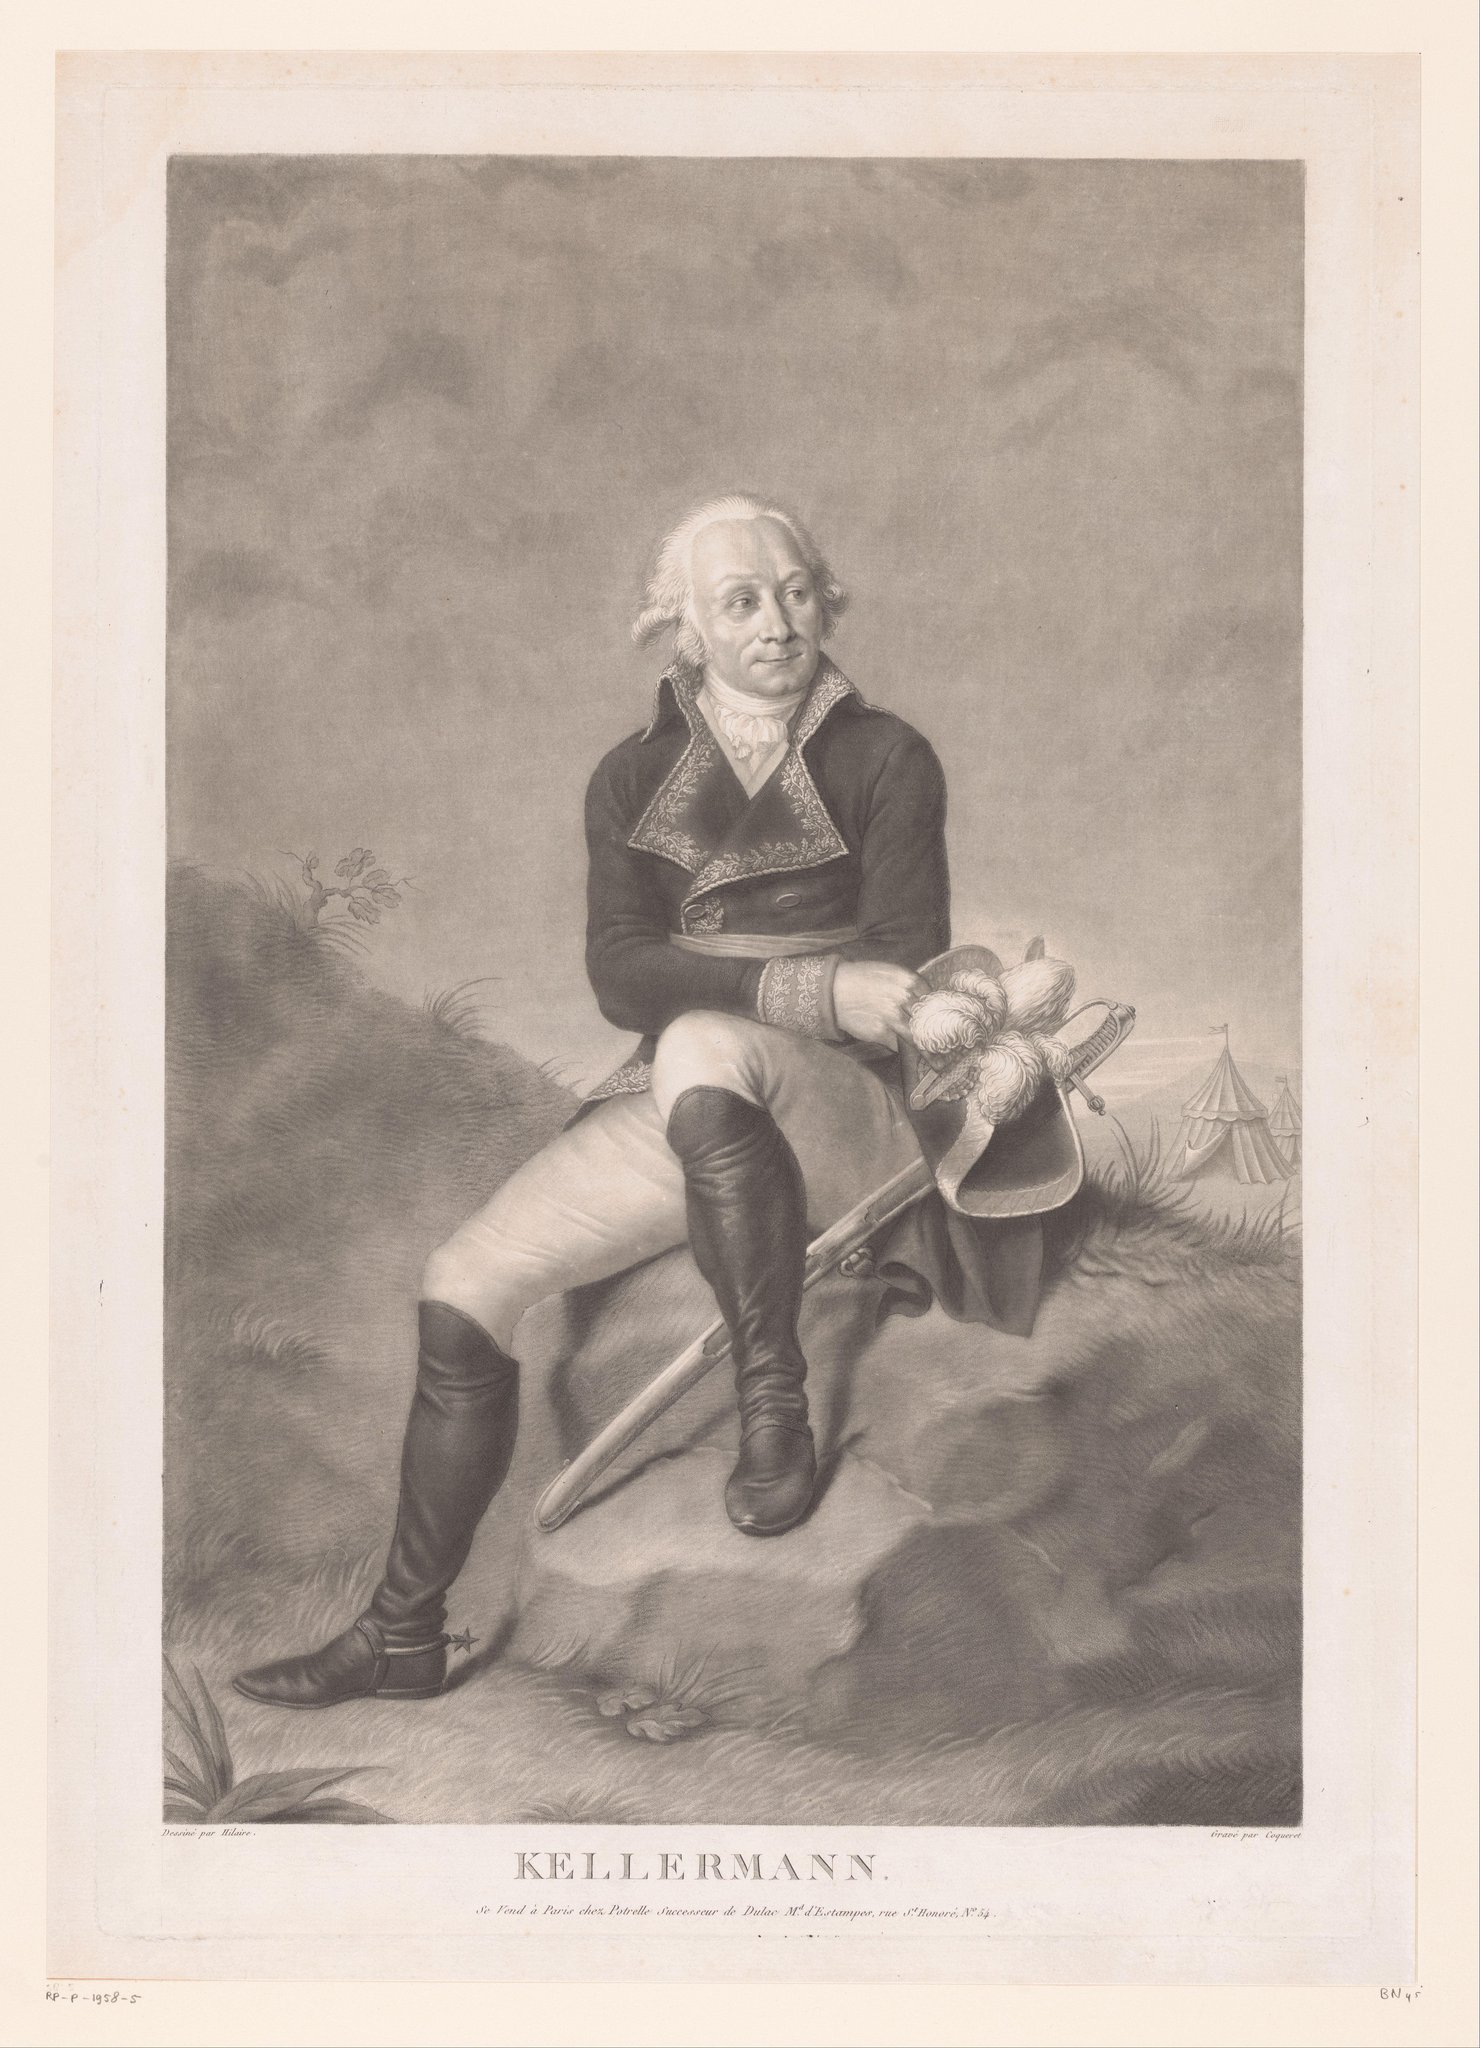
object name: print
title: Portret van François Christophe Kellermann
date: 1803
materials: paper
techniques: aquatint, etching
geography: paris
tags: paris, politician, commander-in-chief, general, marshal, historical persons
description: Maakt deel uit van een serie portretten van generaals tijdens de Franse Republiek, ten voeten uit. De serie werd in twee formaten uitgegeven, in groot formaat en in klein formaat.